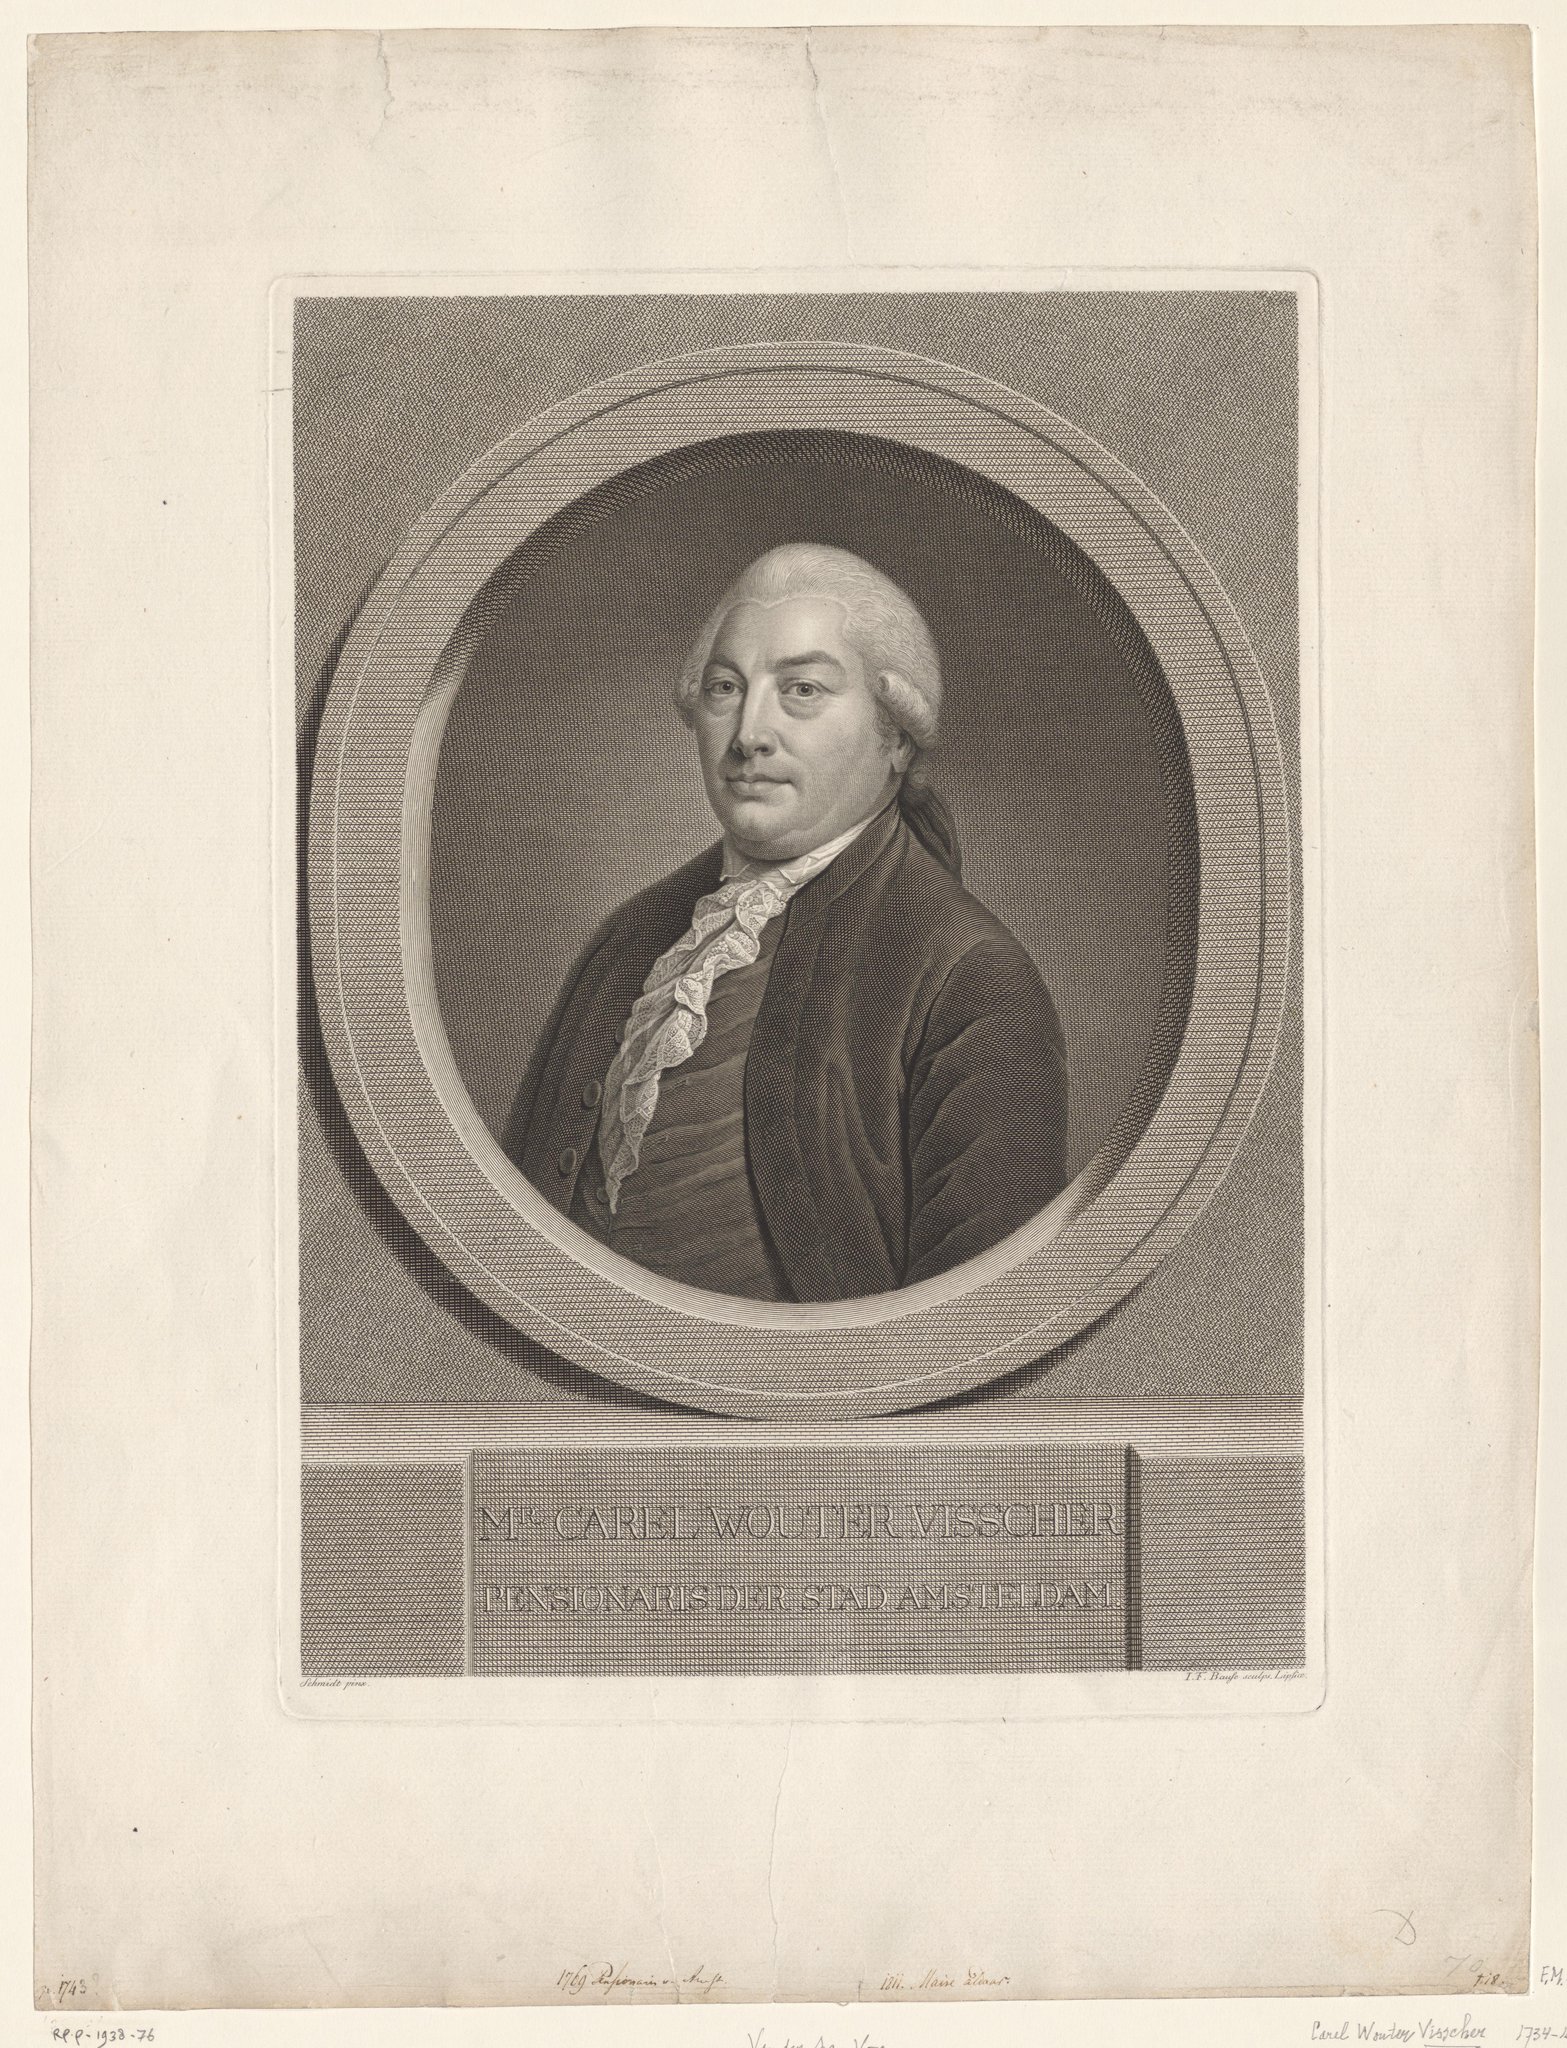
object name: print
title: Portret van Carel Wouter Visscher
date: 1786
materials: paper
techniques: engraving, etching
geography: leipzig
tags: adult man, historical persons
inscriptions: collector's mark: Lugt 2228, inscription: ‘1743/ 1769 Pensionari v amst./ 18II maise aldaar/ +18’